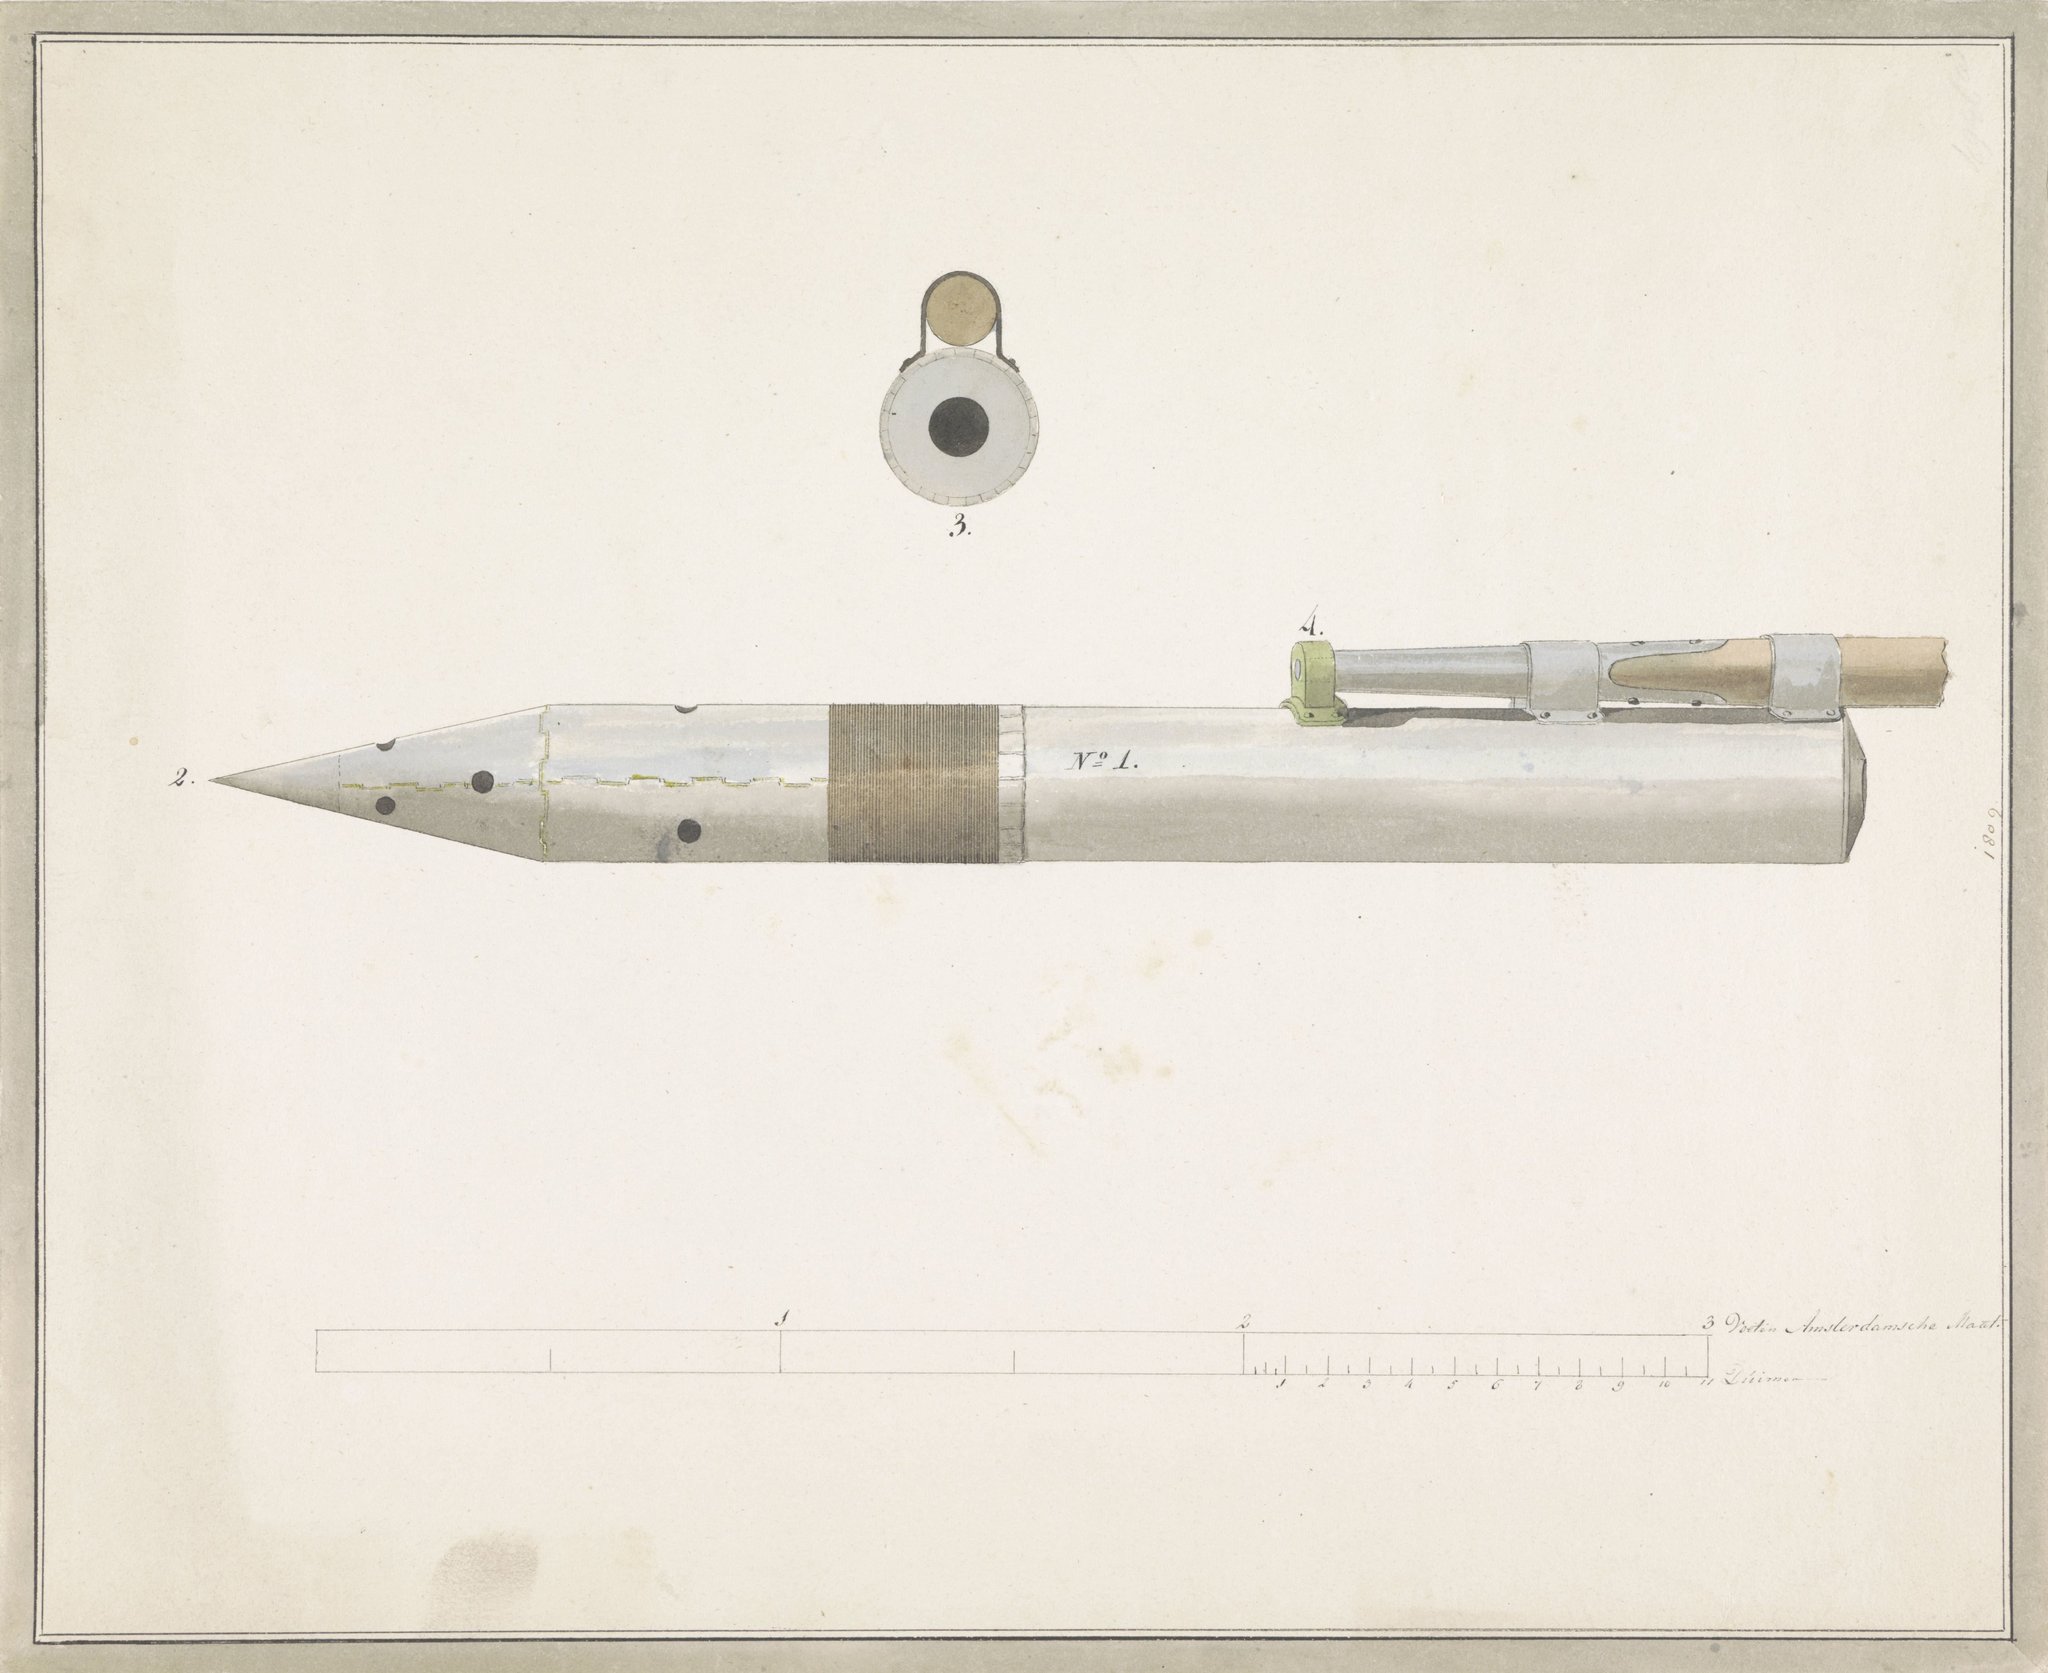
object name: drawing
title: Congreveraket, mogelijk gebruikt door de Engelsen bij het bombardement van Vlissingen, 1809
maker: Anonymous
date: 1809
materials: paper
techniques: brush, pen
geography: netherlands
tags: bombardment (+ weapons)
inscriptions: collector's mark: Lugt 2228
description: Congreveraket, zoals mogelijk gebruikt door de Engelsen bij het bombardement van Vlissingen op 13 augustus 1809. Lengteaanzicht en doorsnede van de raket (vuurpijl), de onderdelen genummerd, onderaan een schaalstok. Bij de tekening behoort een handschrift over het wapen.